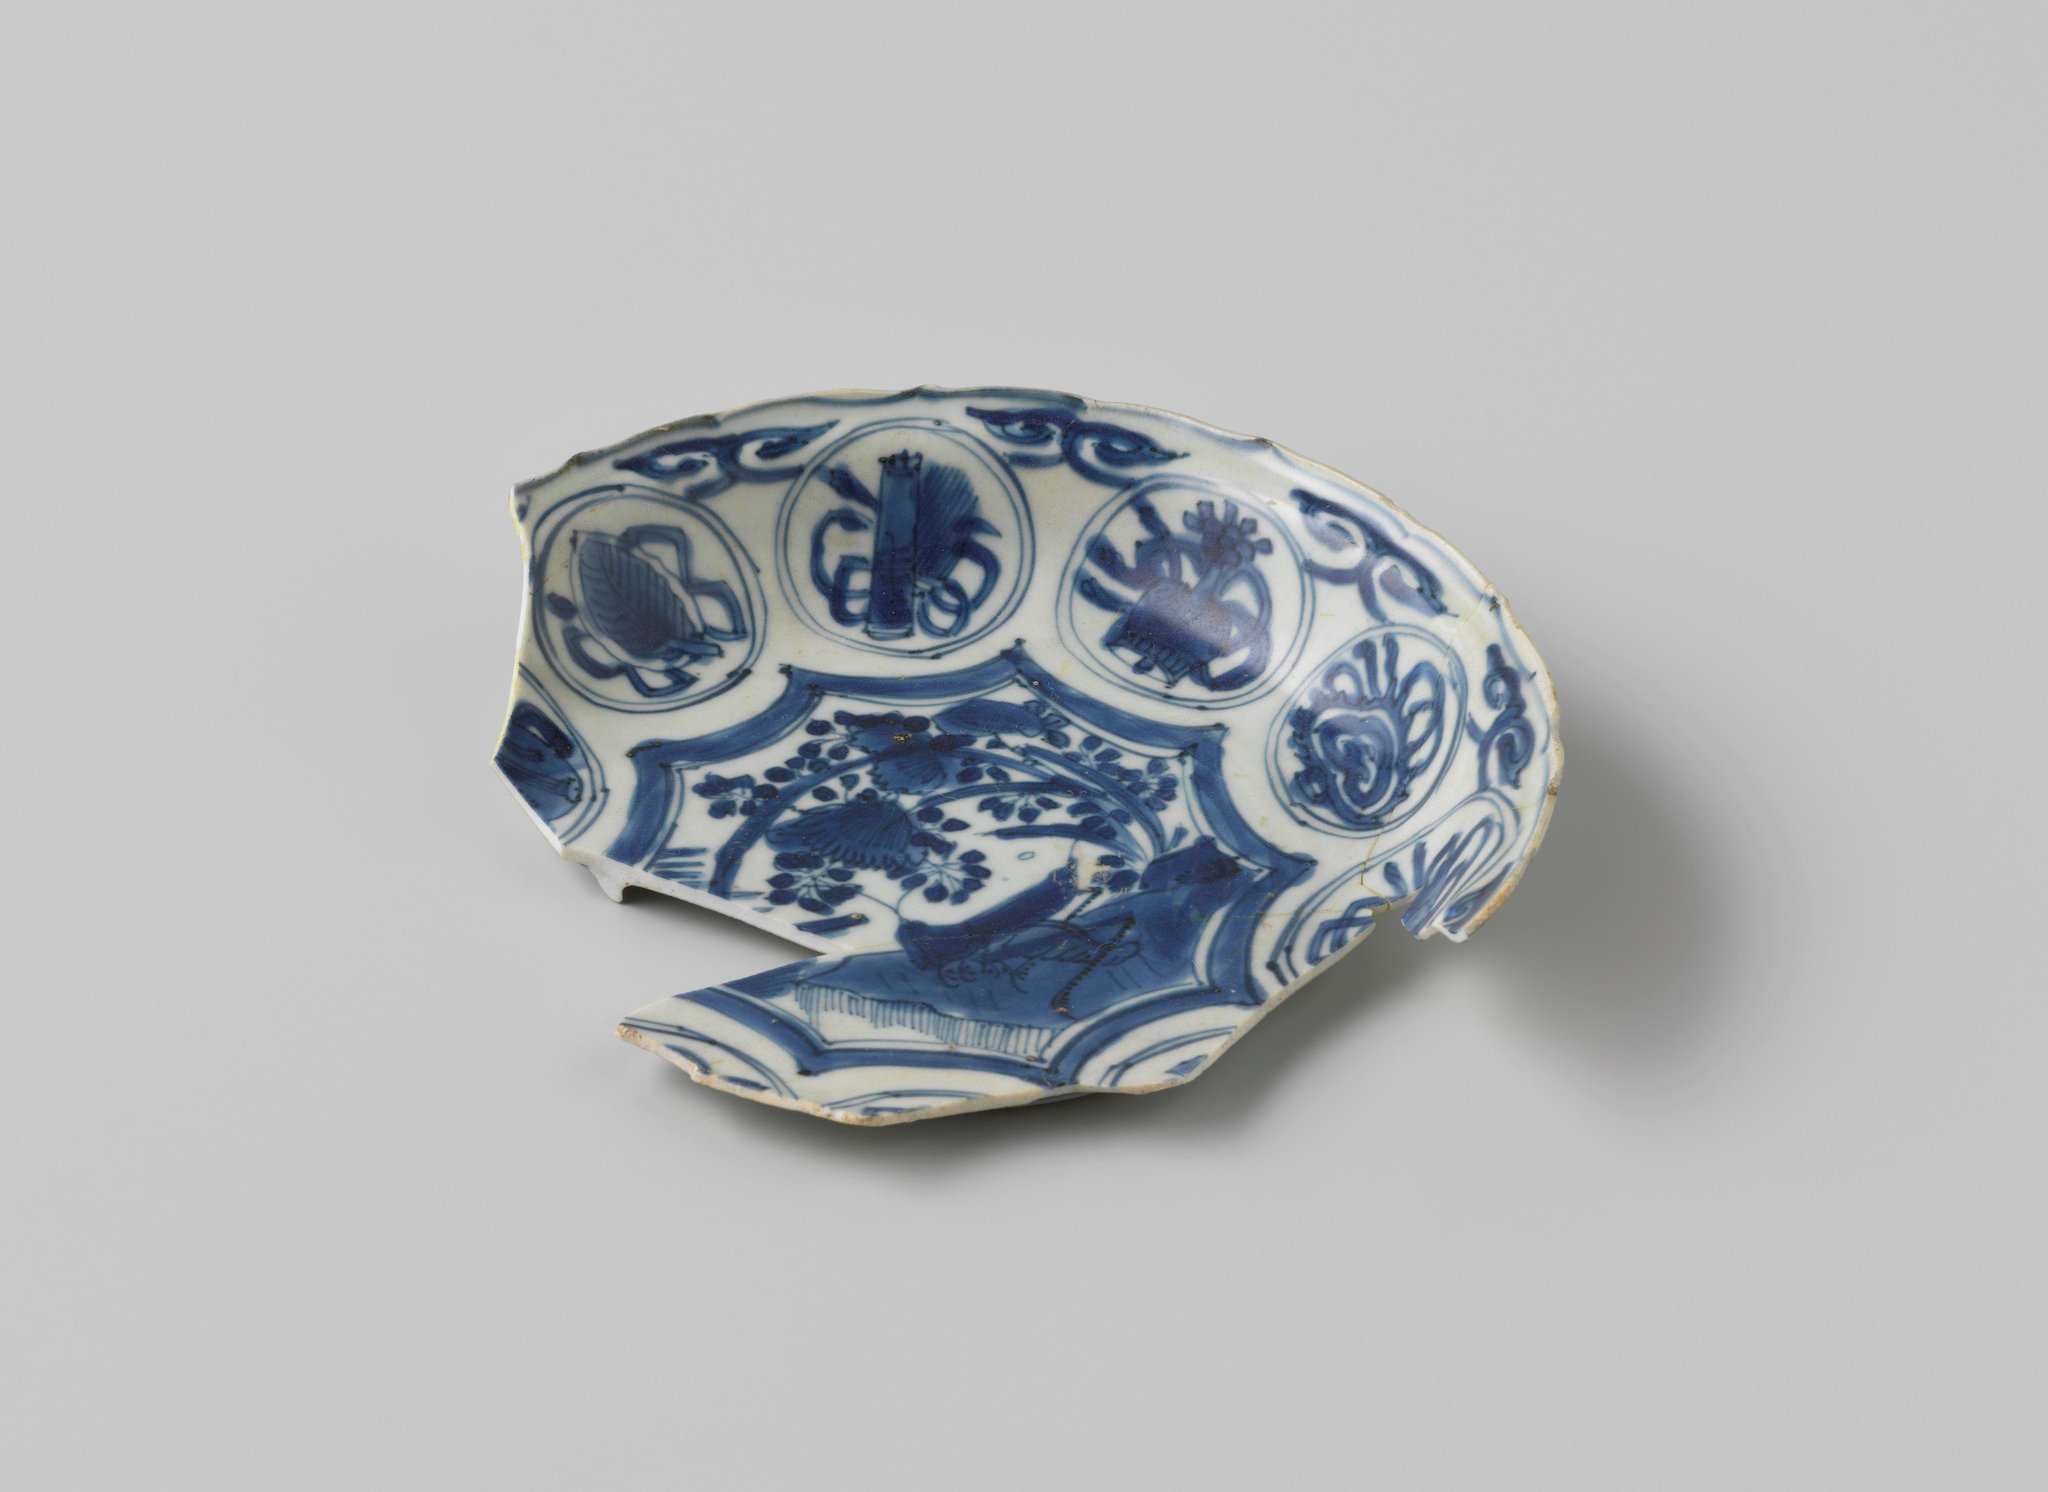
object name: plate dish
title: Fragment bord uit V.O.C.-schip de 'Witte Leeuw'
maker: Anonymous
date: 1613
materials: bone china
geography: jingdezhen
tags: verenigde oostindische compagnie, sint-helena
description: A dish without a flattened rim. An eight-sided thickly drawn medallion. A central decoration of a grasshopper on a rock under a flower. The medallions decoratedonly with symbols; a typical one is a bell with a flower.